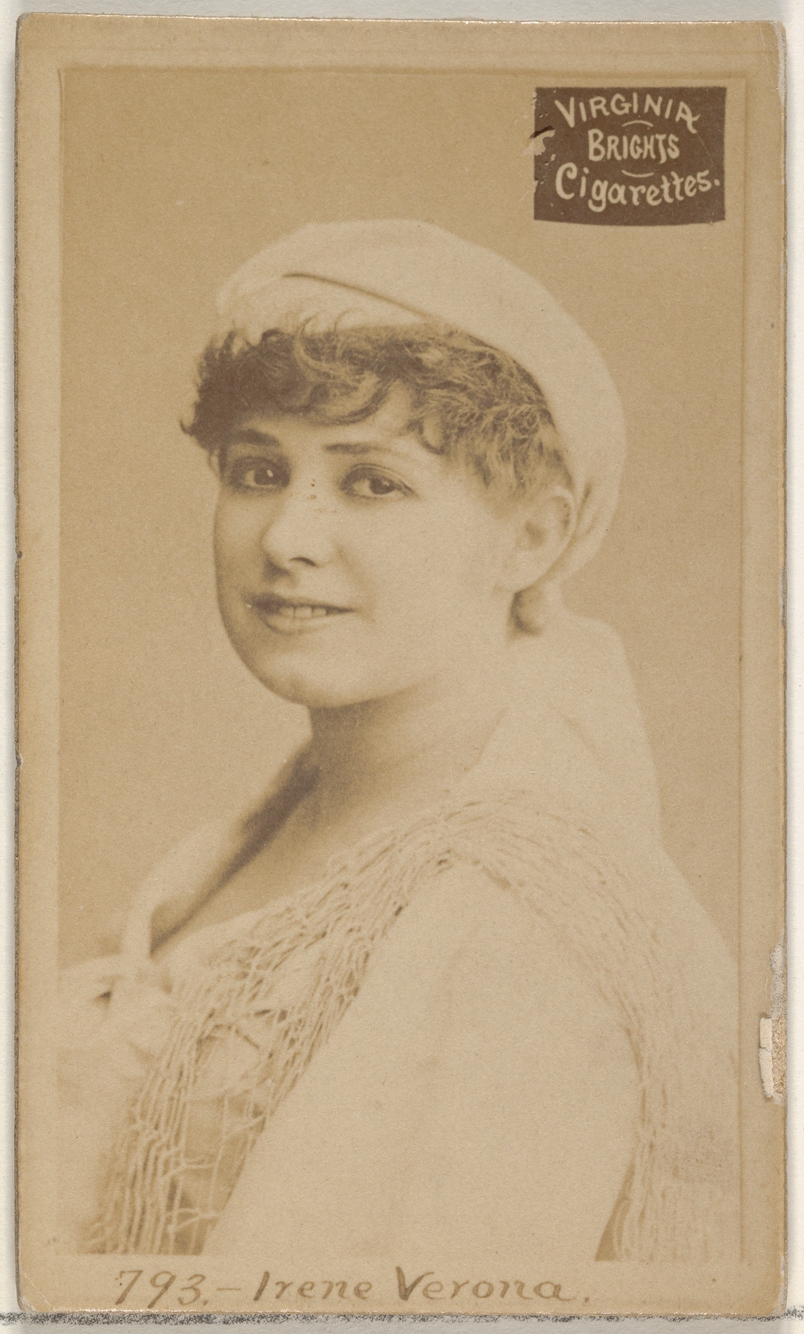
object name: photograph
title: Card 793, Irene Verona, from the Actors and Actresses series (N45, Type 2) for Virginia Brights Cigarettes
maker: allen & ginter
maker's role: publisher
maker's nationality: american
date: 1888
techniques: albumen silver print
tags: portraits,women,actresses